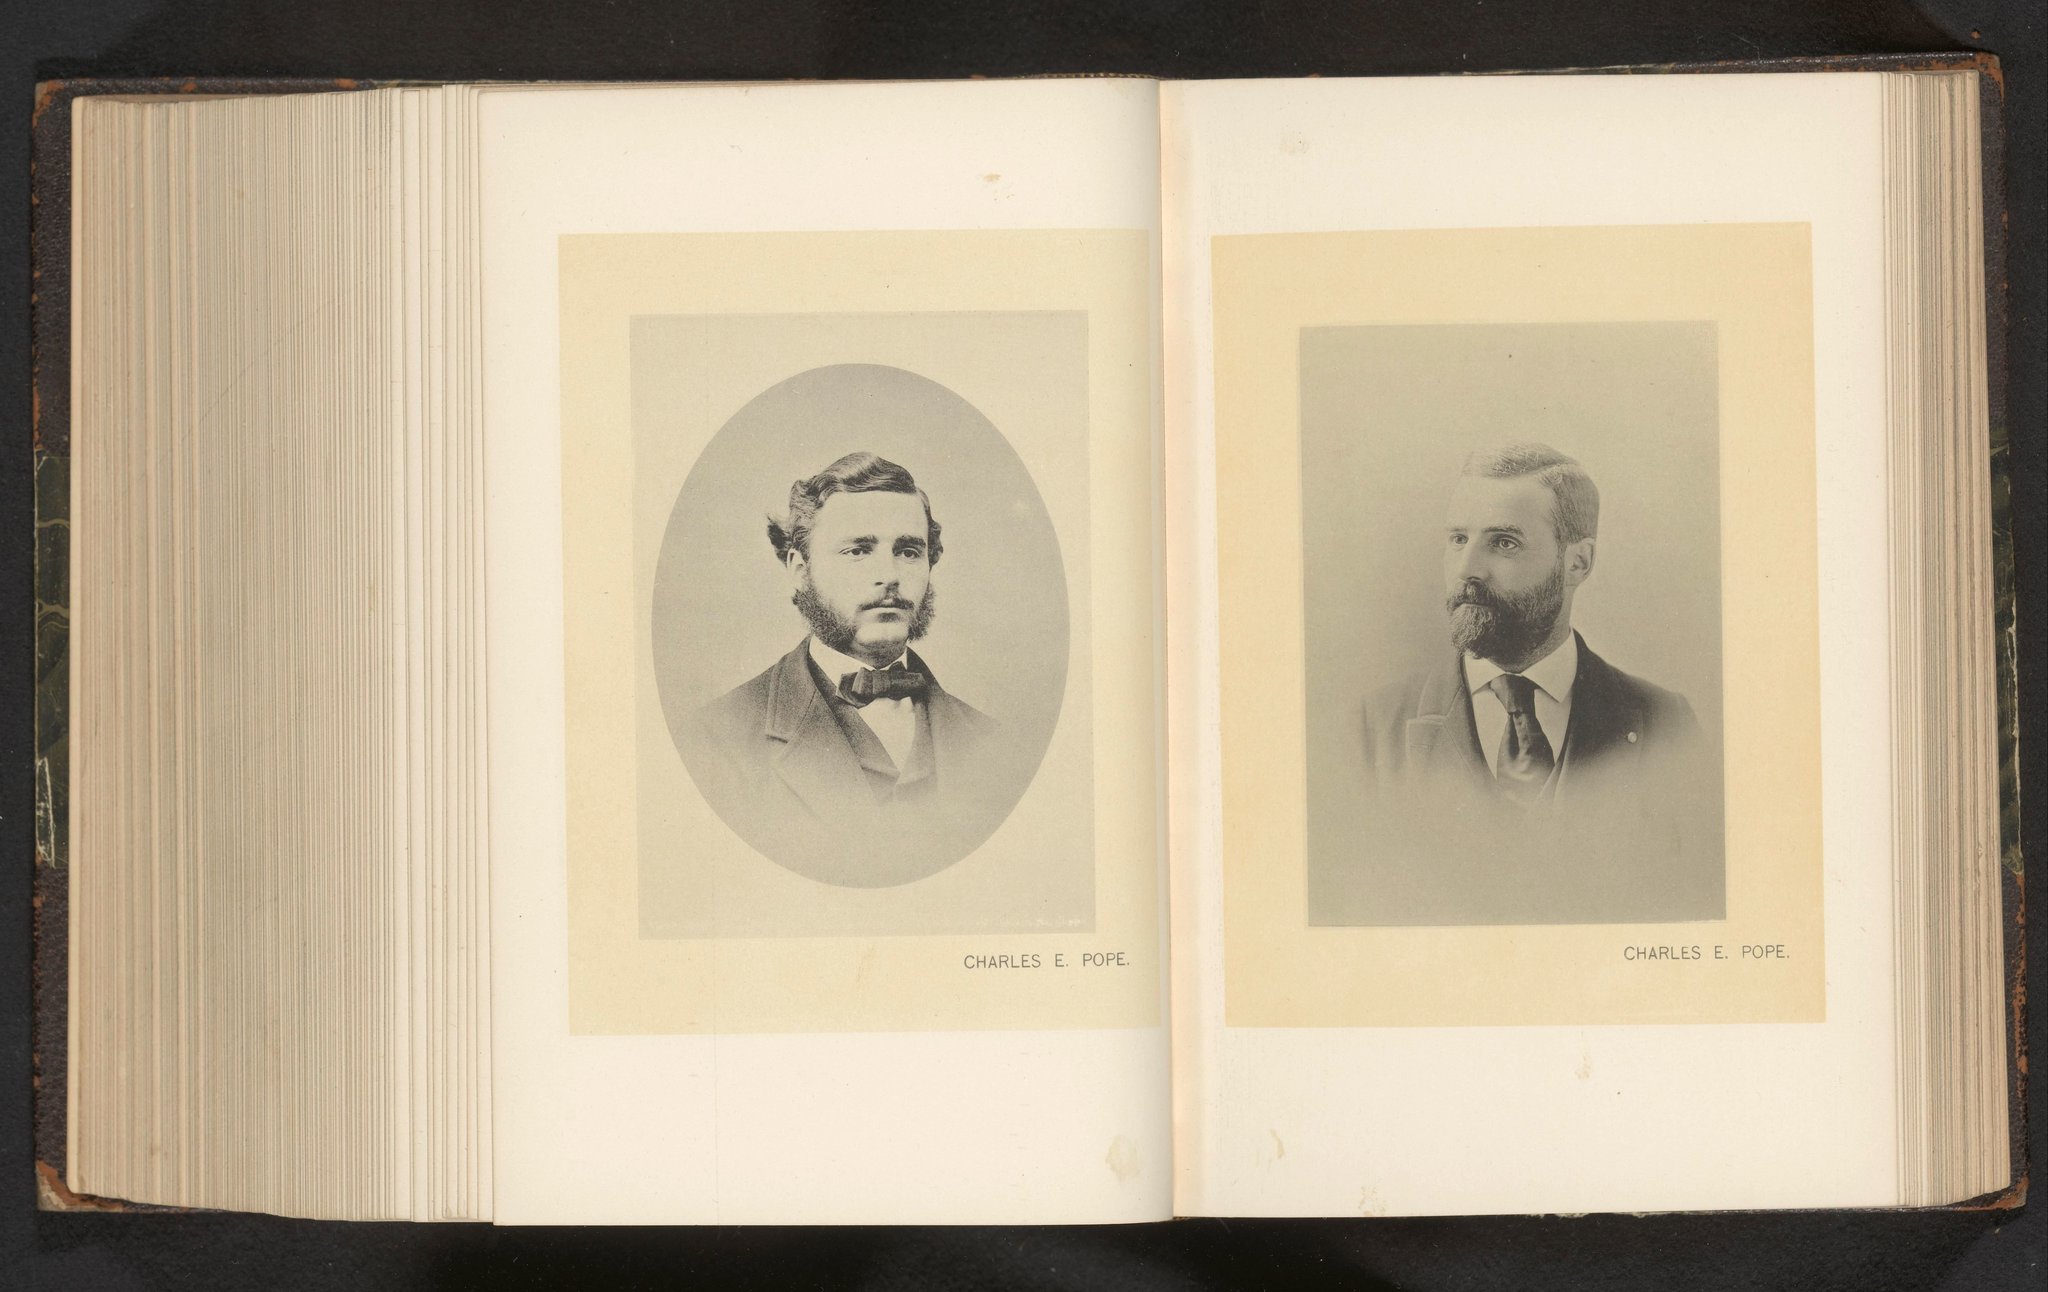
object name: photomechanical print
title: Charles E. Pope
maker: Anonymous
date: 1869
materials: paper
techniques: photoaquatint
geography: boston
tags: adult man